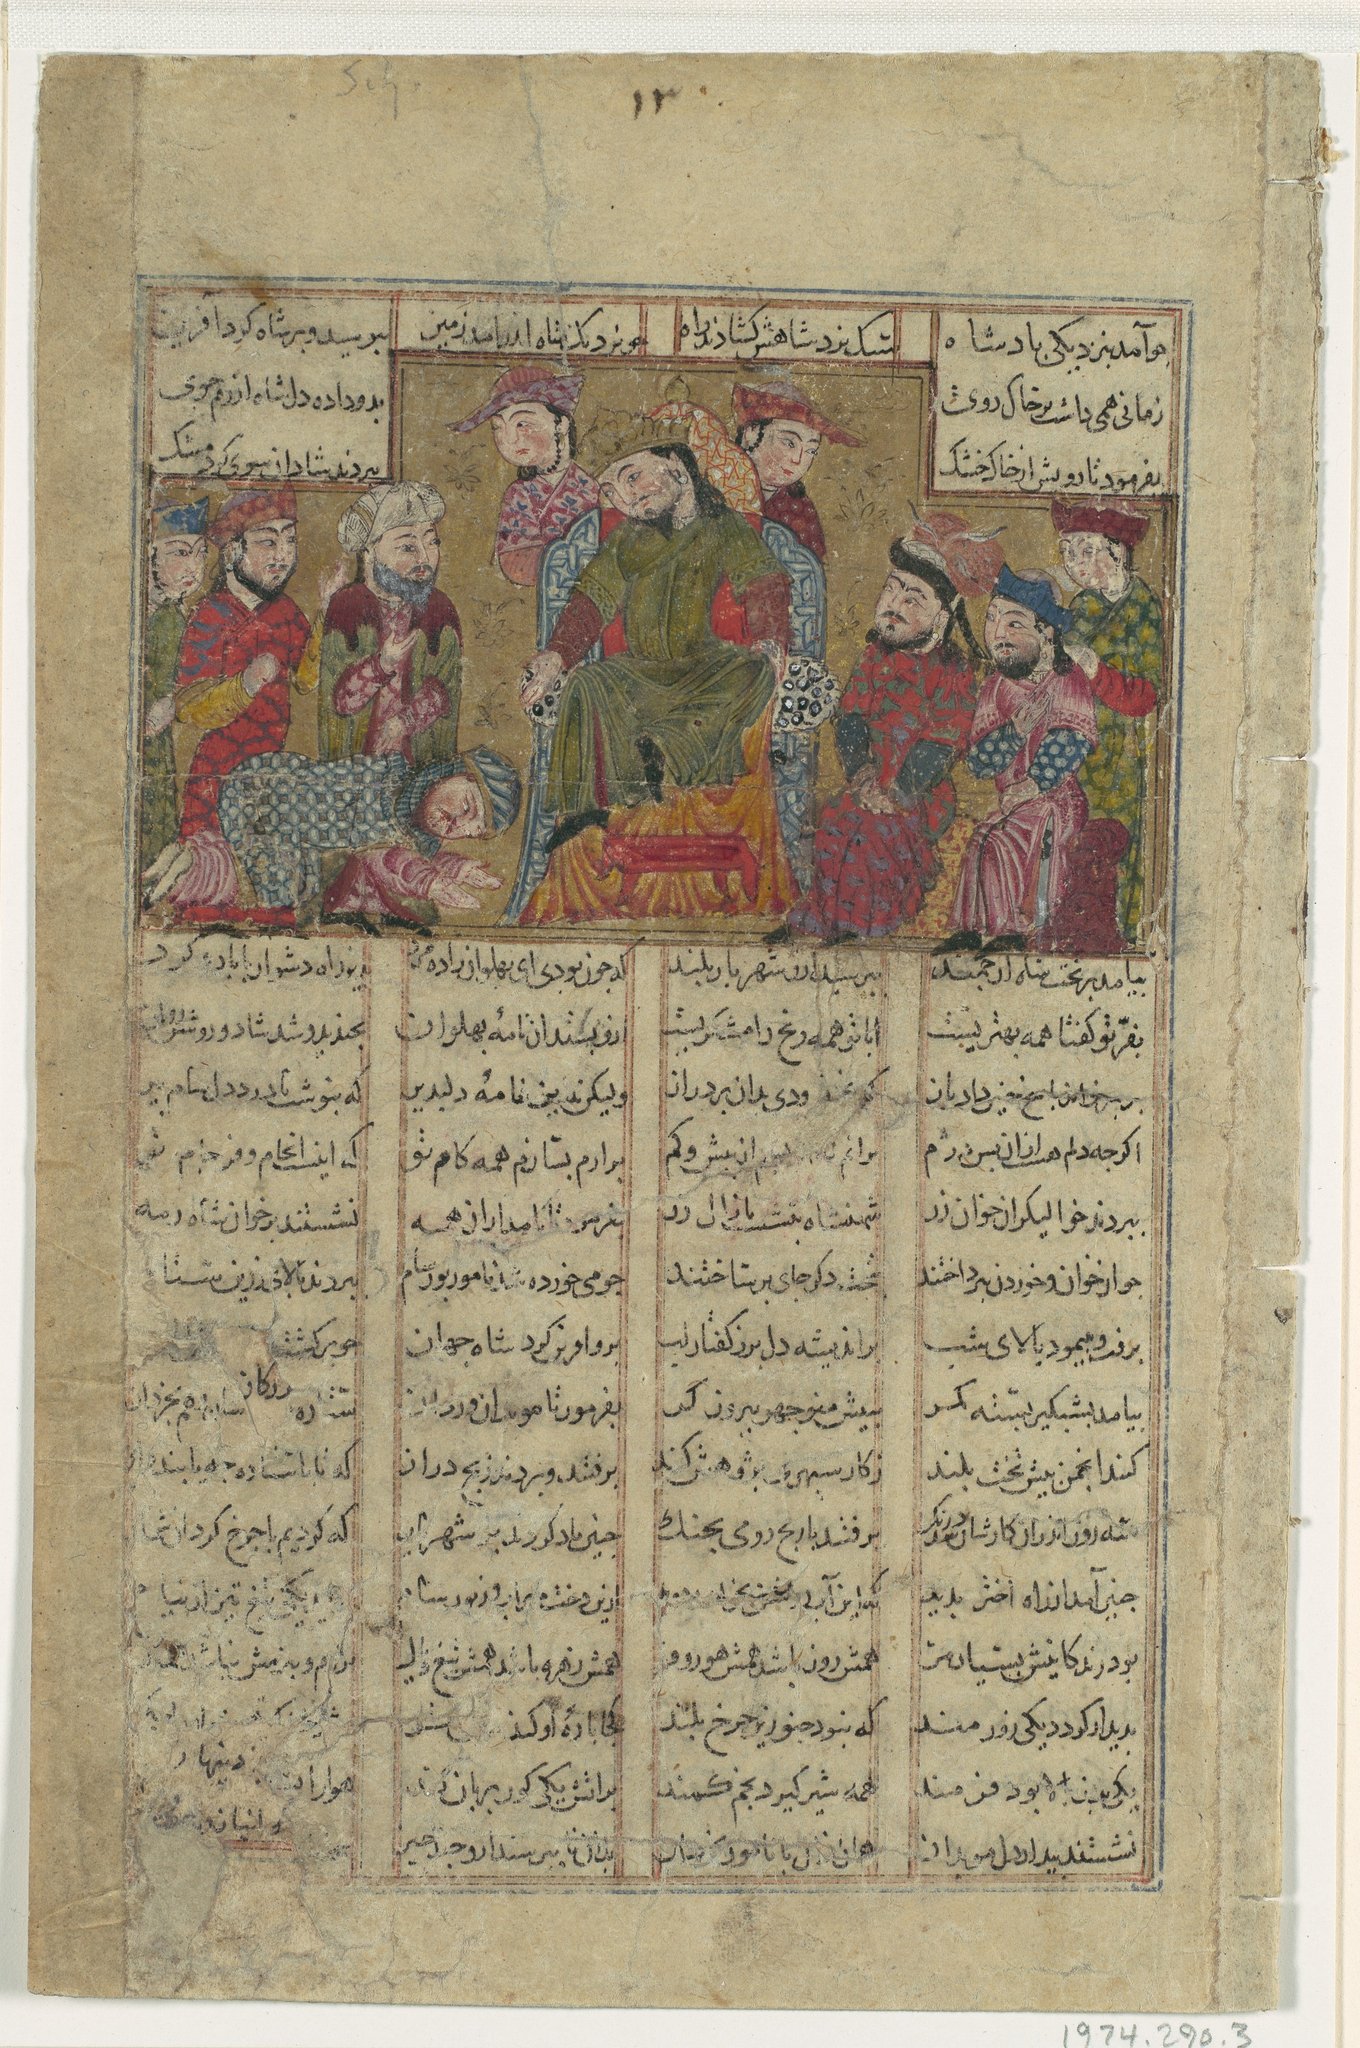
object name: folio from an illustrated manuscript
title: "Zal delivers Sam's letter to Manuchihr", Folio from a Shahnama (Book of Kings) of Firdausi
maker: abu'l qasim firdausi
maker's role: author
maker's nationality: iranian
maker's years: 935-1020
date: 1330-1340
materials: gold, ink, paper, silver, watercolor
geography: iran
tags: kings,men